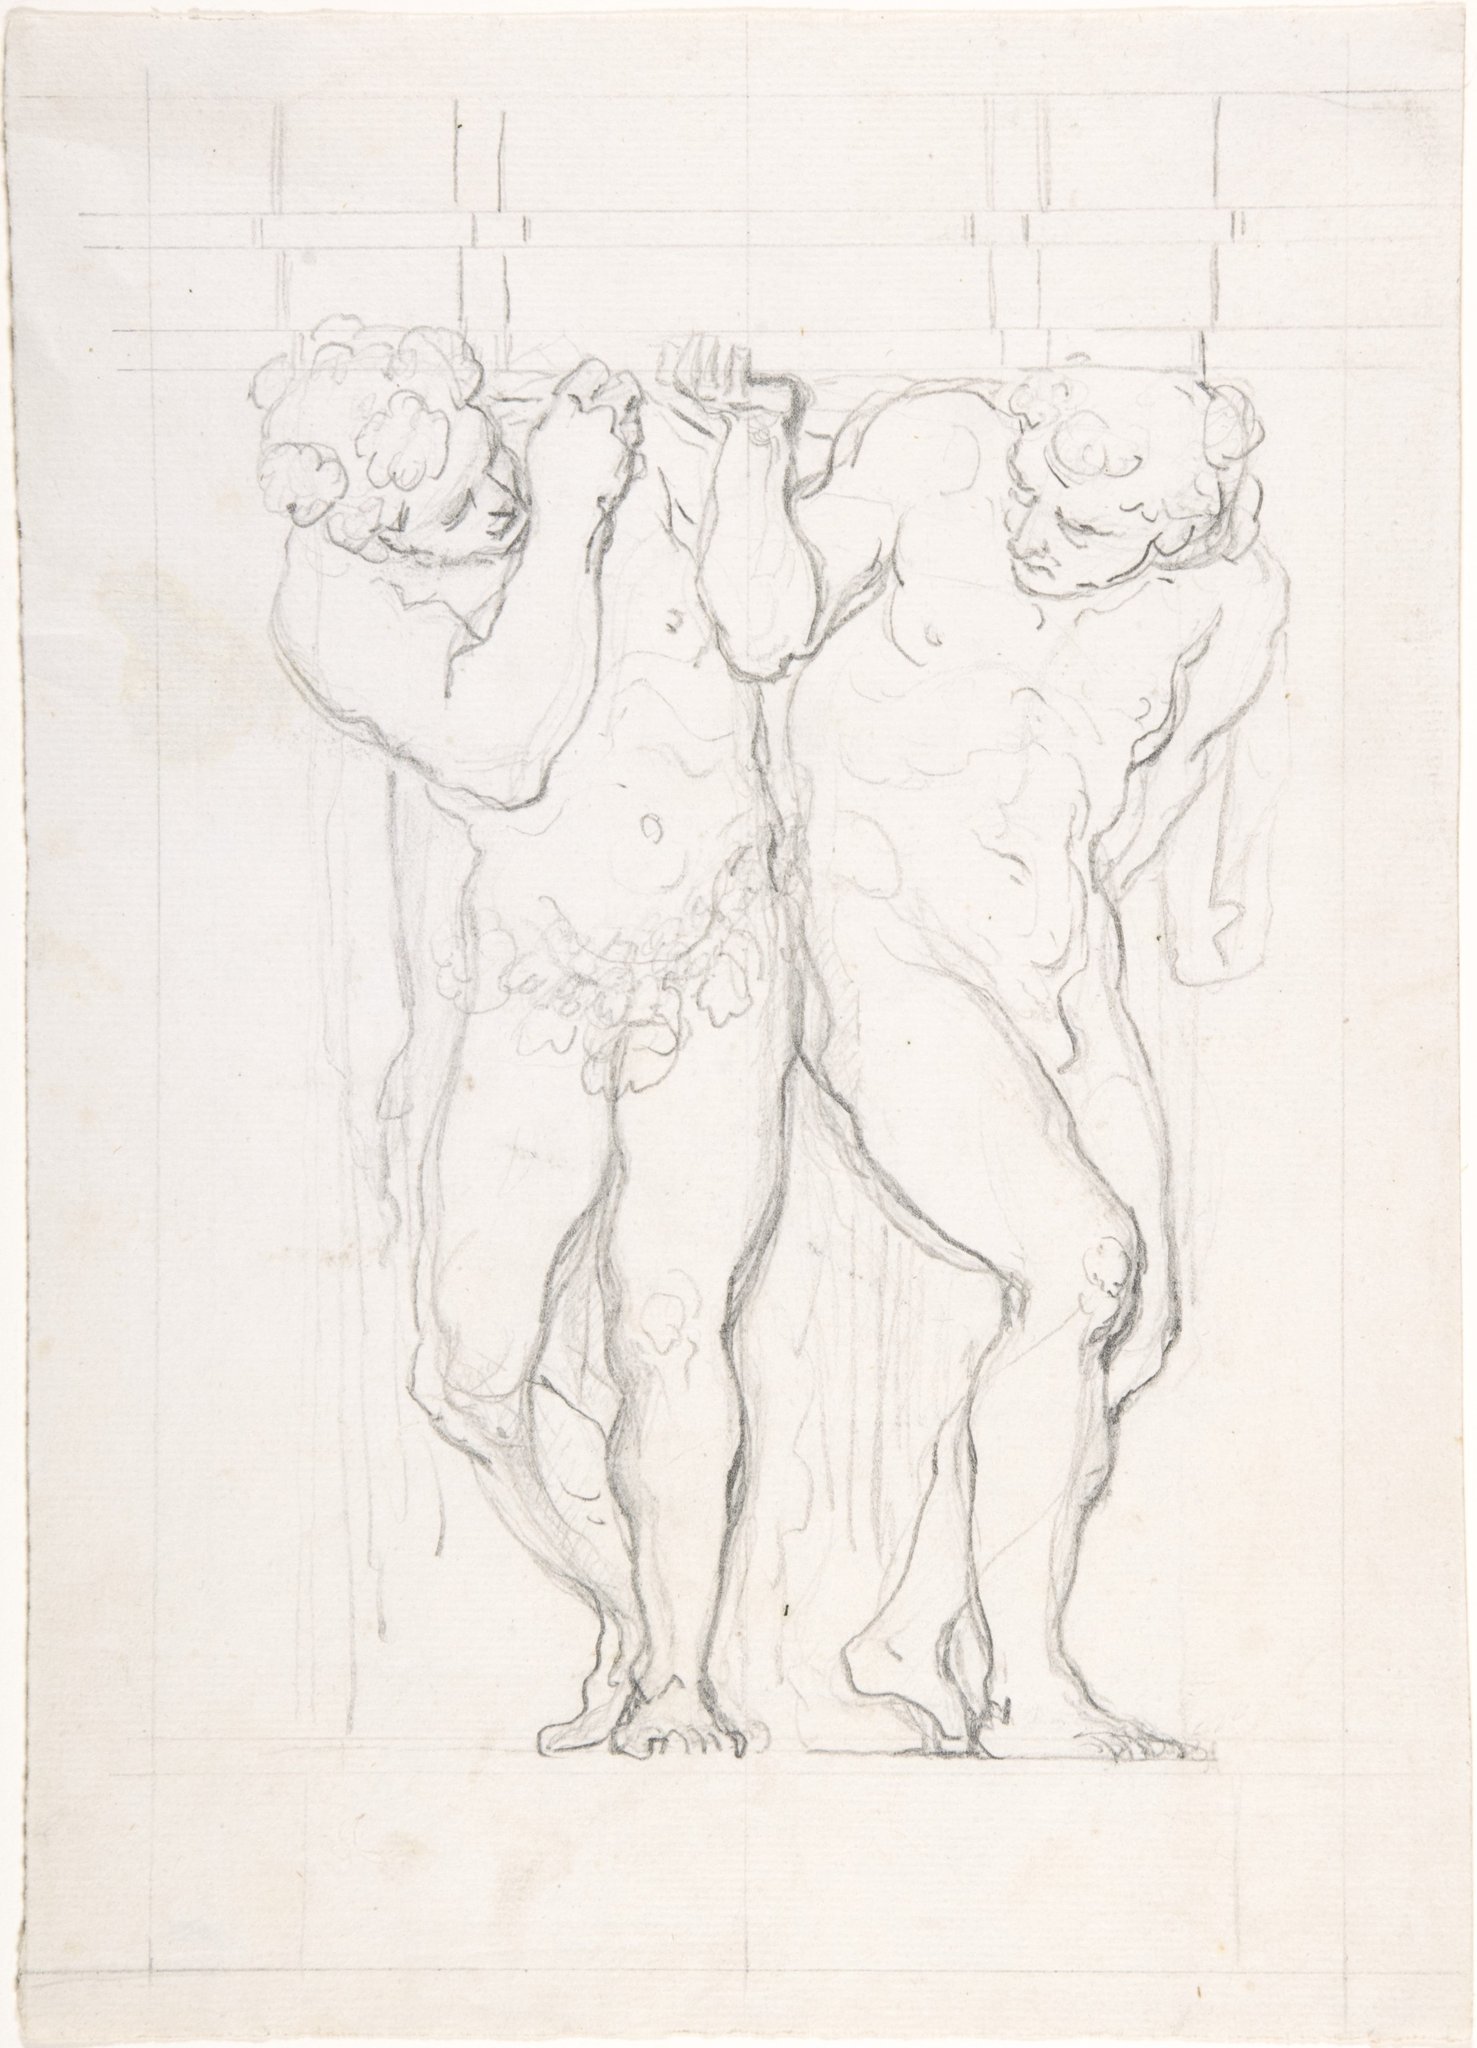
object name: drawing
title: Two Atlantes in Conversation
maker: honoré daumier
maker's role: artist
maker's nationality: french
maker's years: 1808-1879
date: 1855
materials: graphite, paper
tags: male nudes